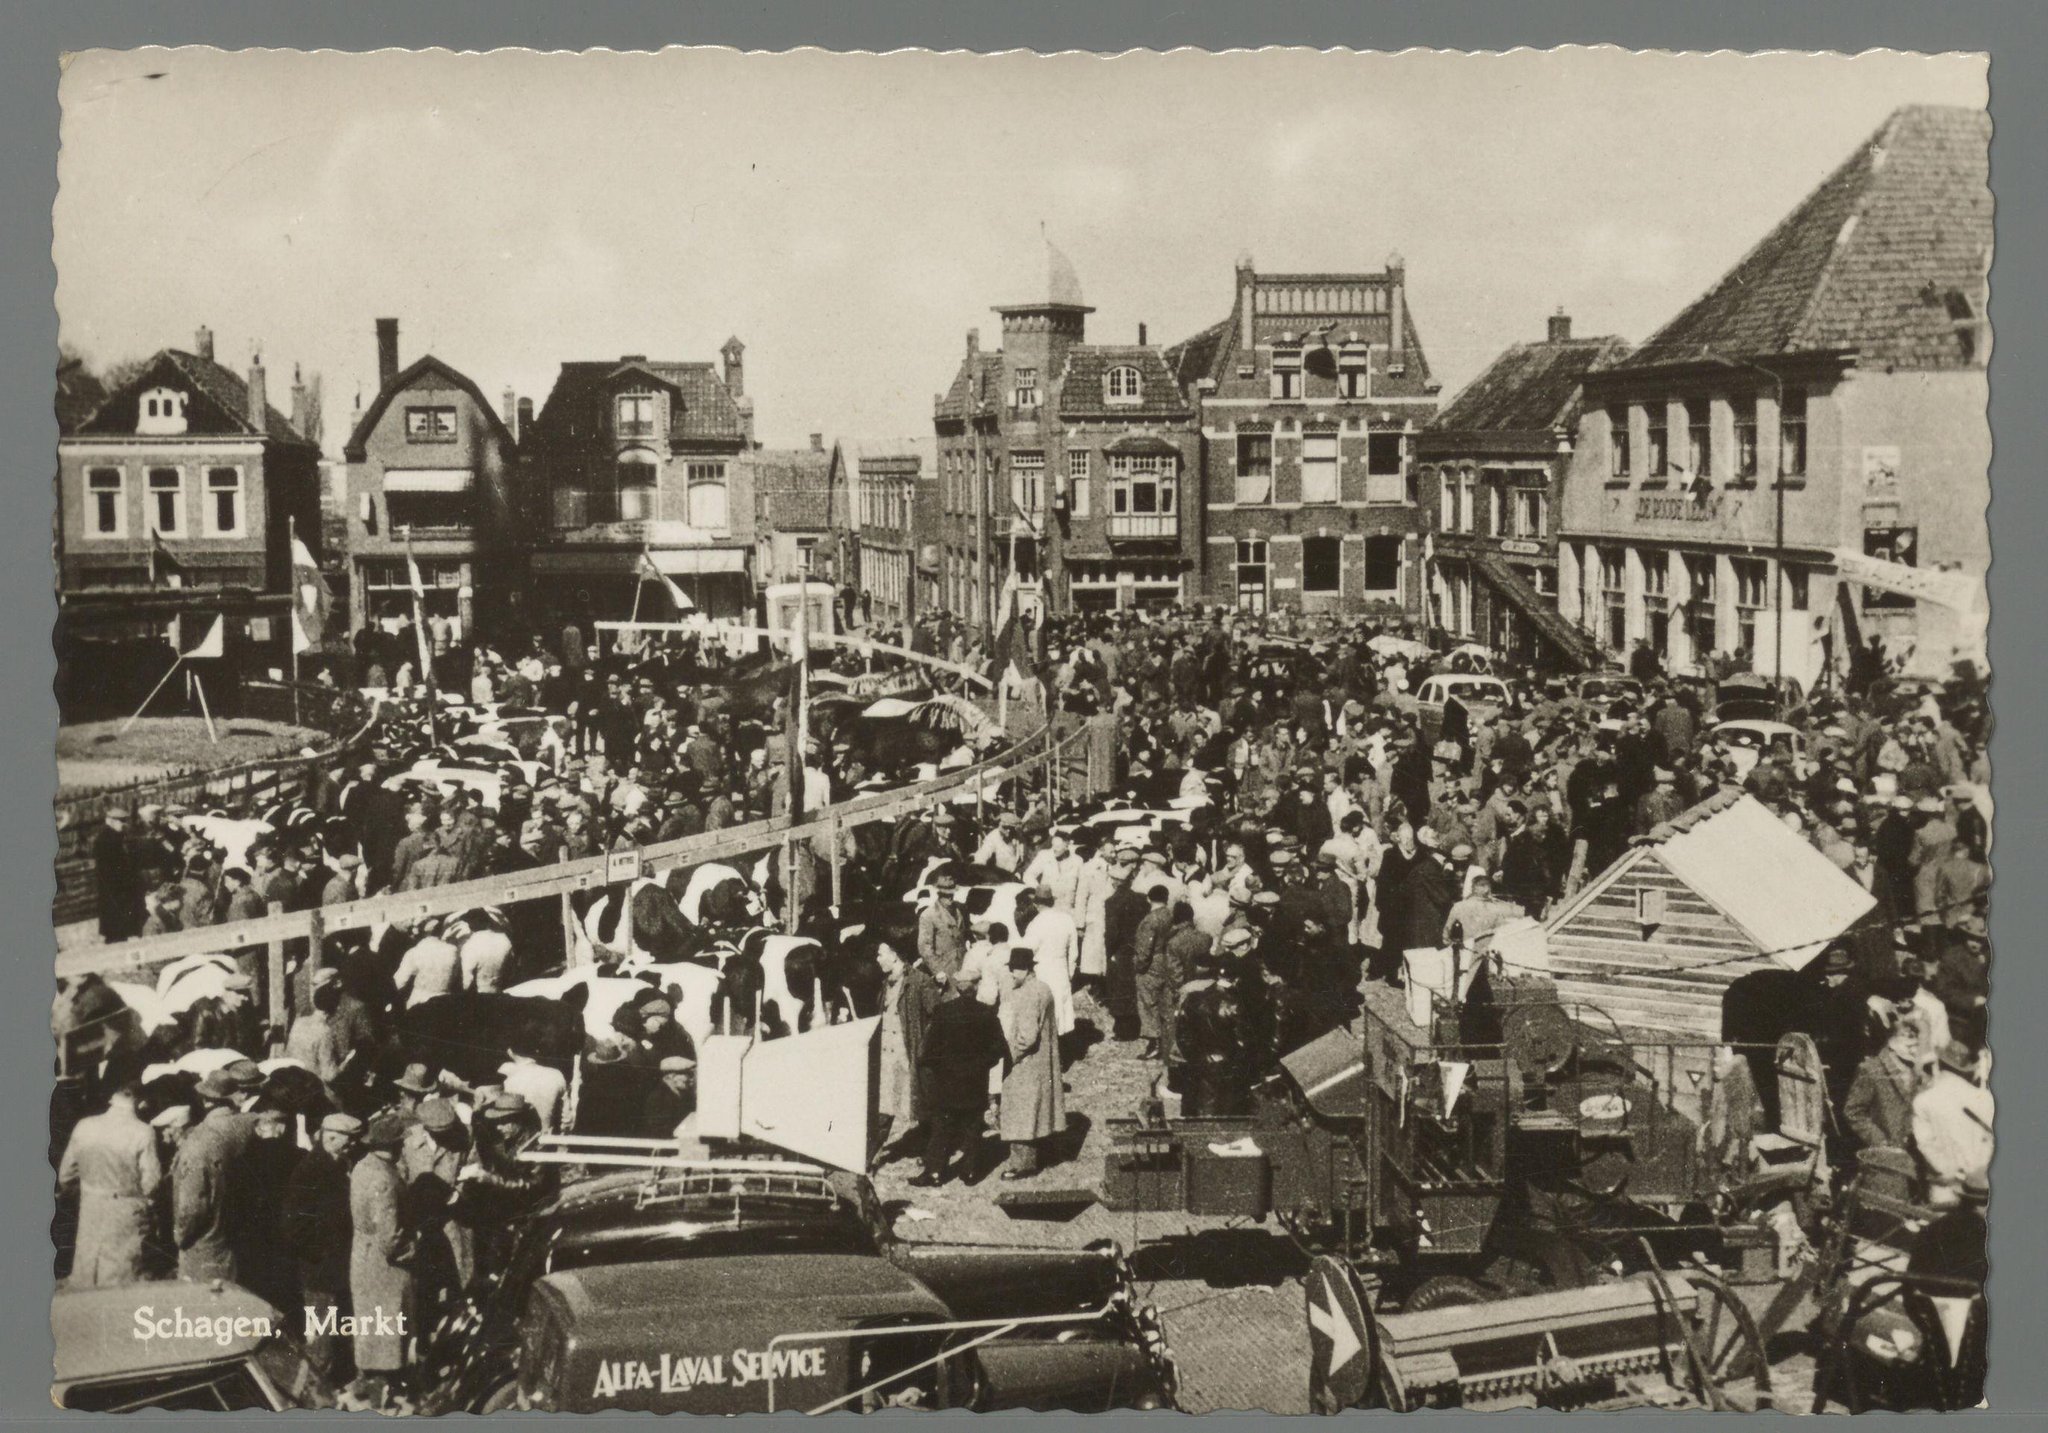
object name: photograph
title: Schagen, Markt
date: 1907-1956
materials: photographic support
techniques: photography, writing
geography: schagen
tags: city-view, and landscape with man-made constructions, cow, schagen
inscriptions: postage stamp